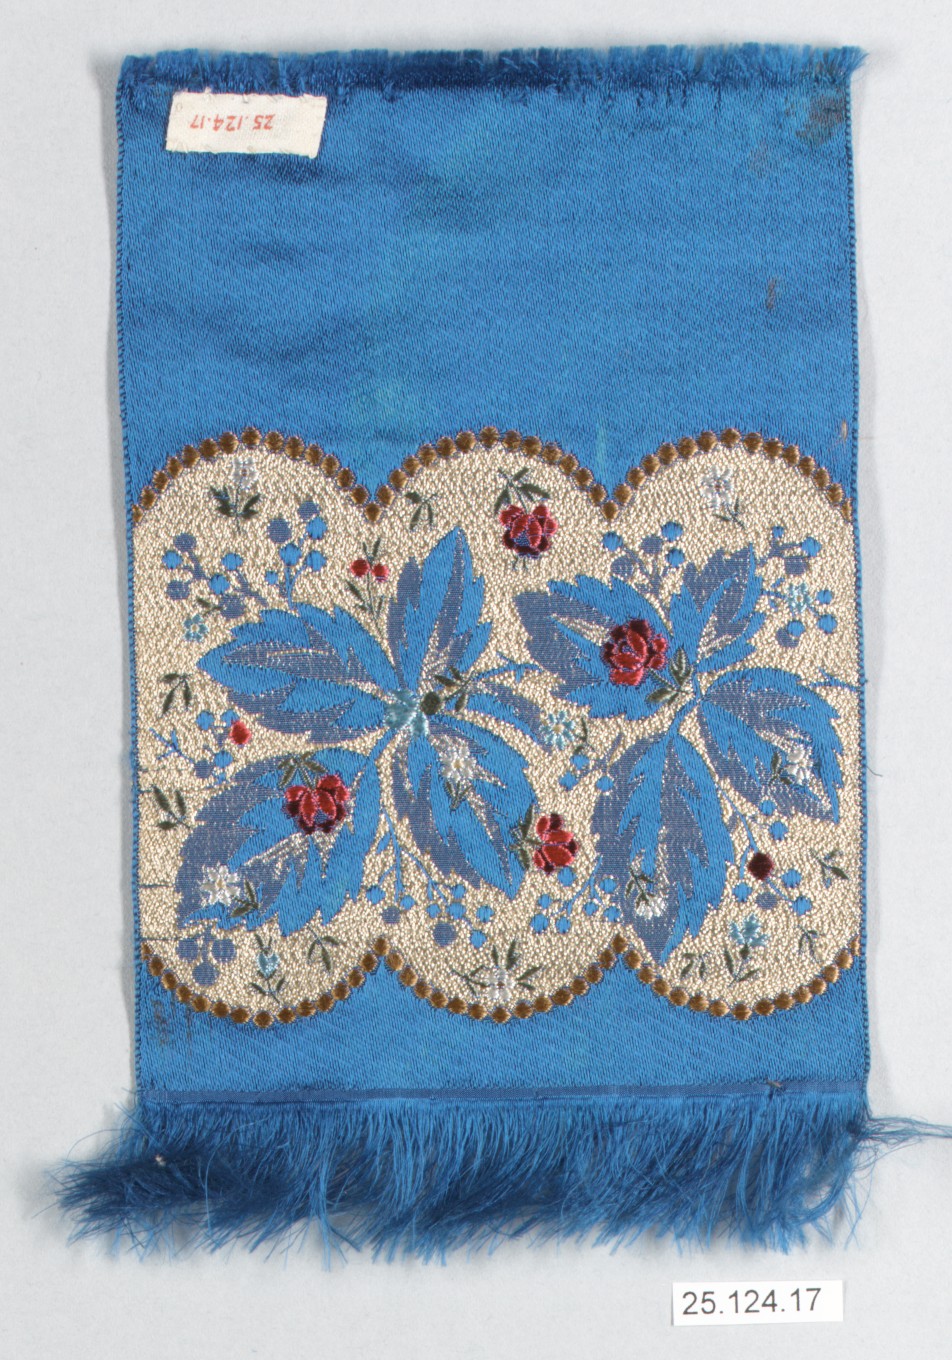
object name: necktie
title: Woman's necktie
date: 1870-1880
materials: silk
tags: flowers,leaves